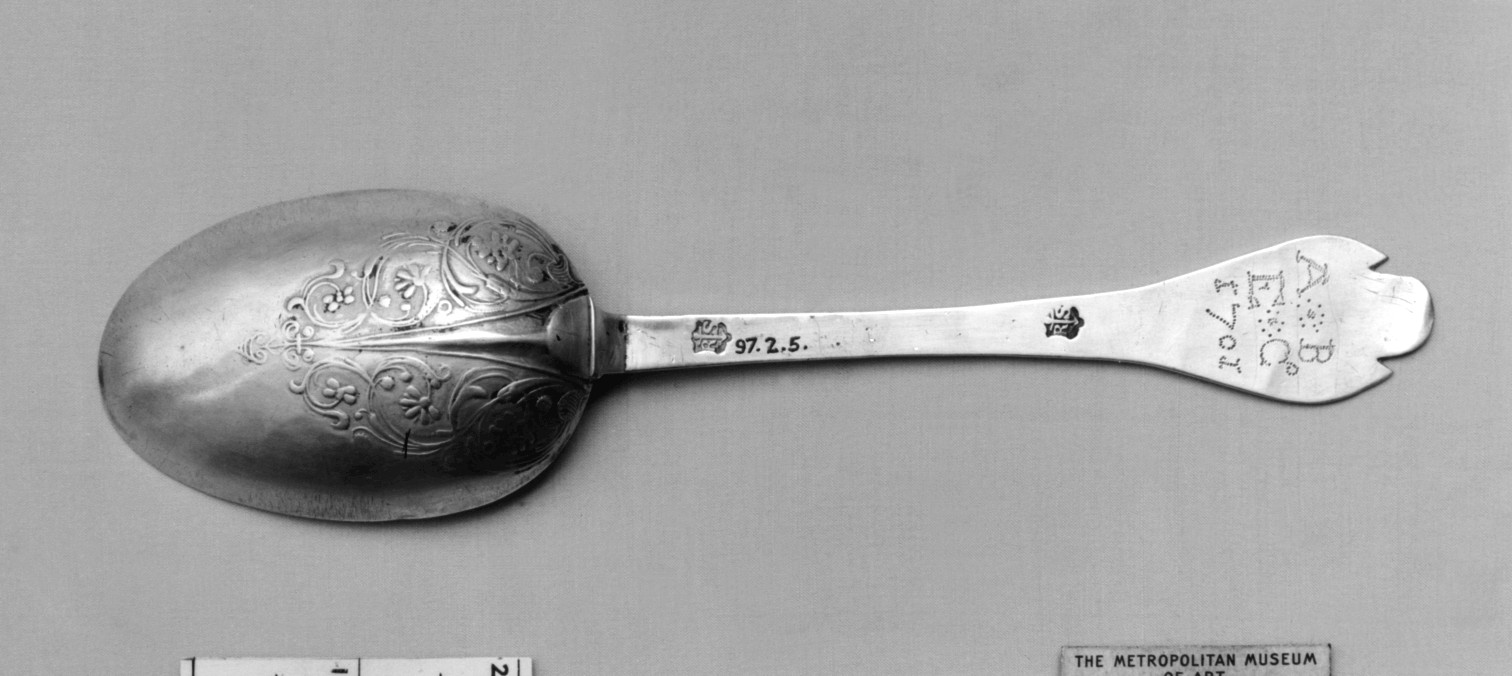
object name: trifid spoon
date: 1680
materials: silver